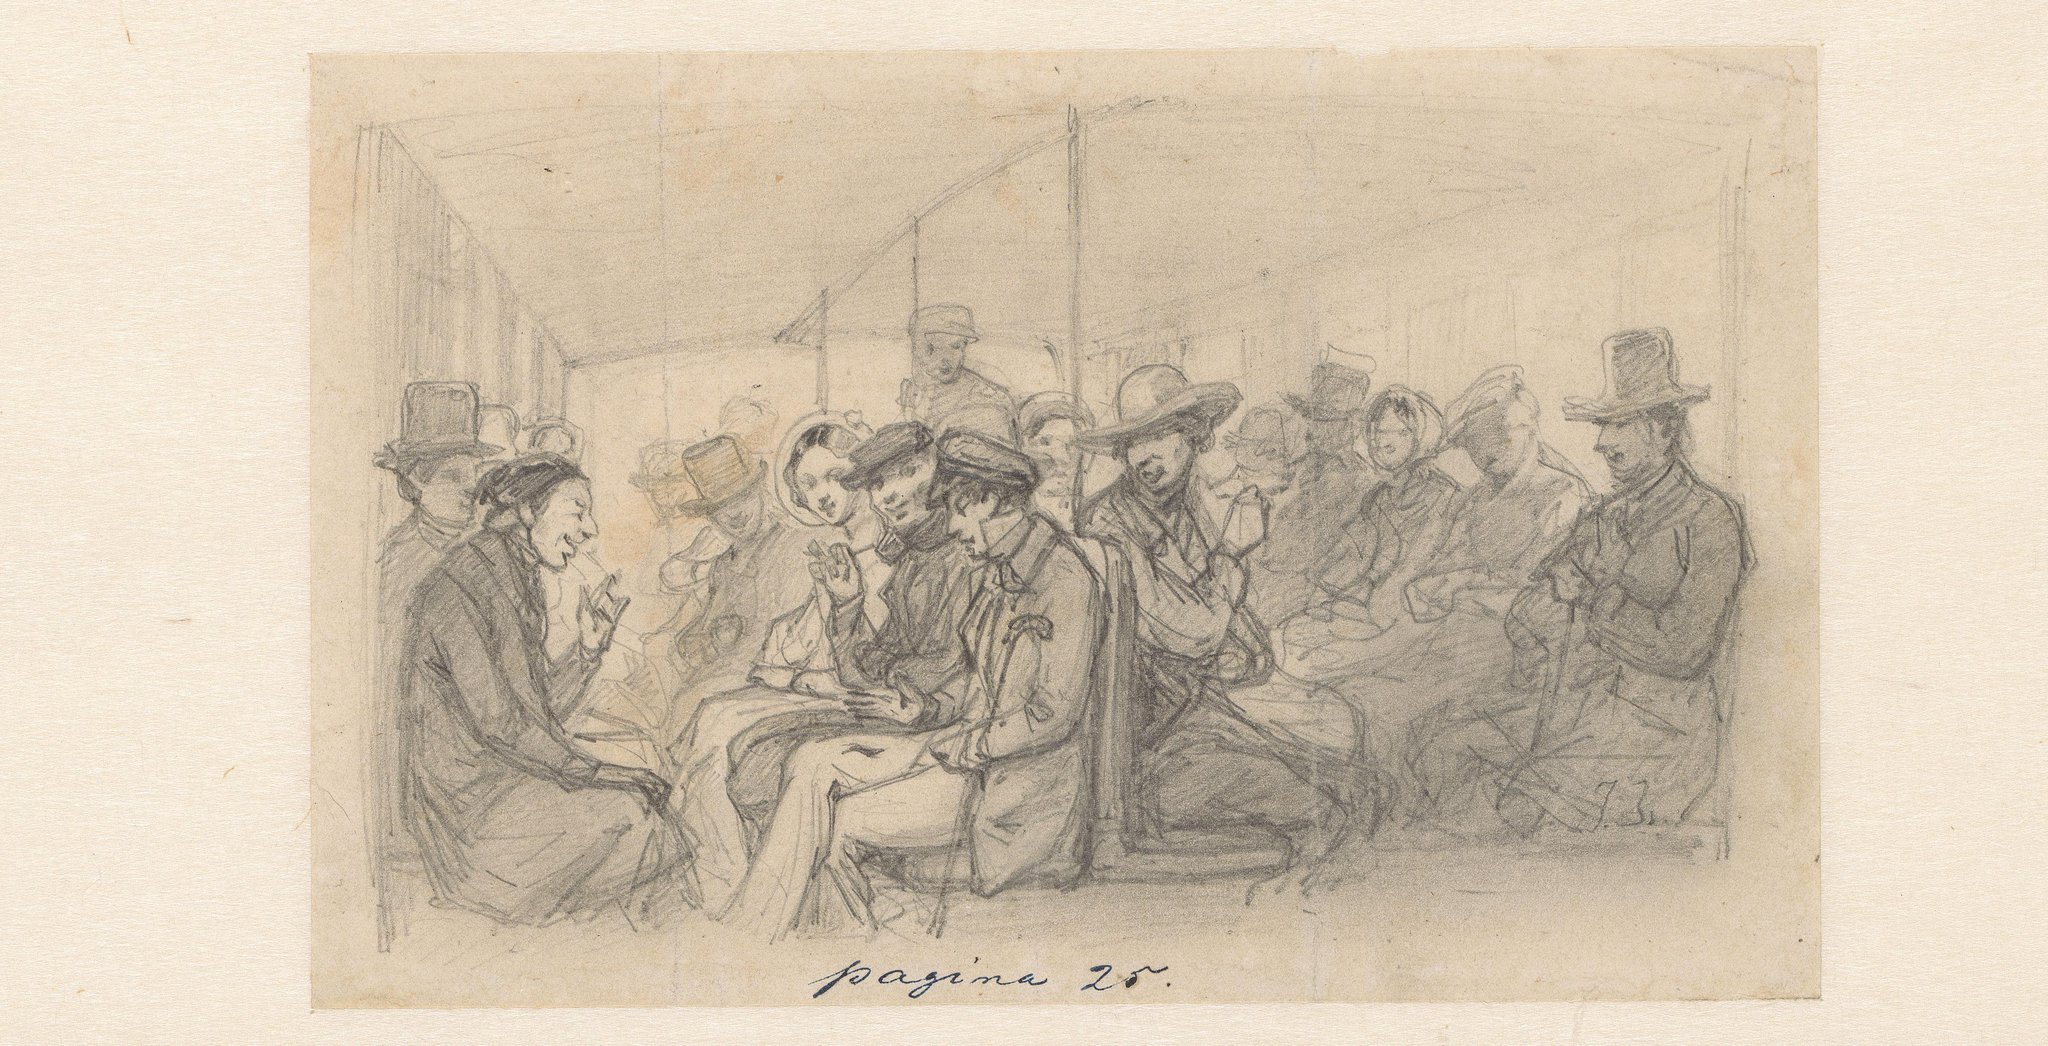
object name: drawing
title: Passagiers in een trekschuit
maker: Anonymous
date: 1800-1900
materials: paper, pencil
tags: passengers ~ ship, tow-boat, towing-barge (+ interior ~ vehicle, ship, etc.)